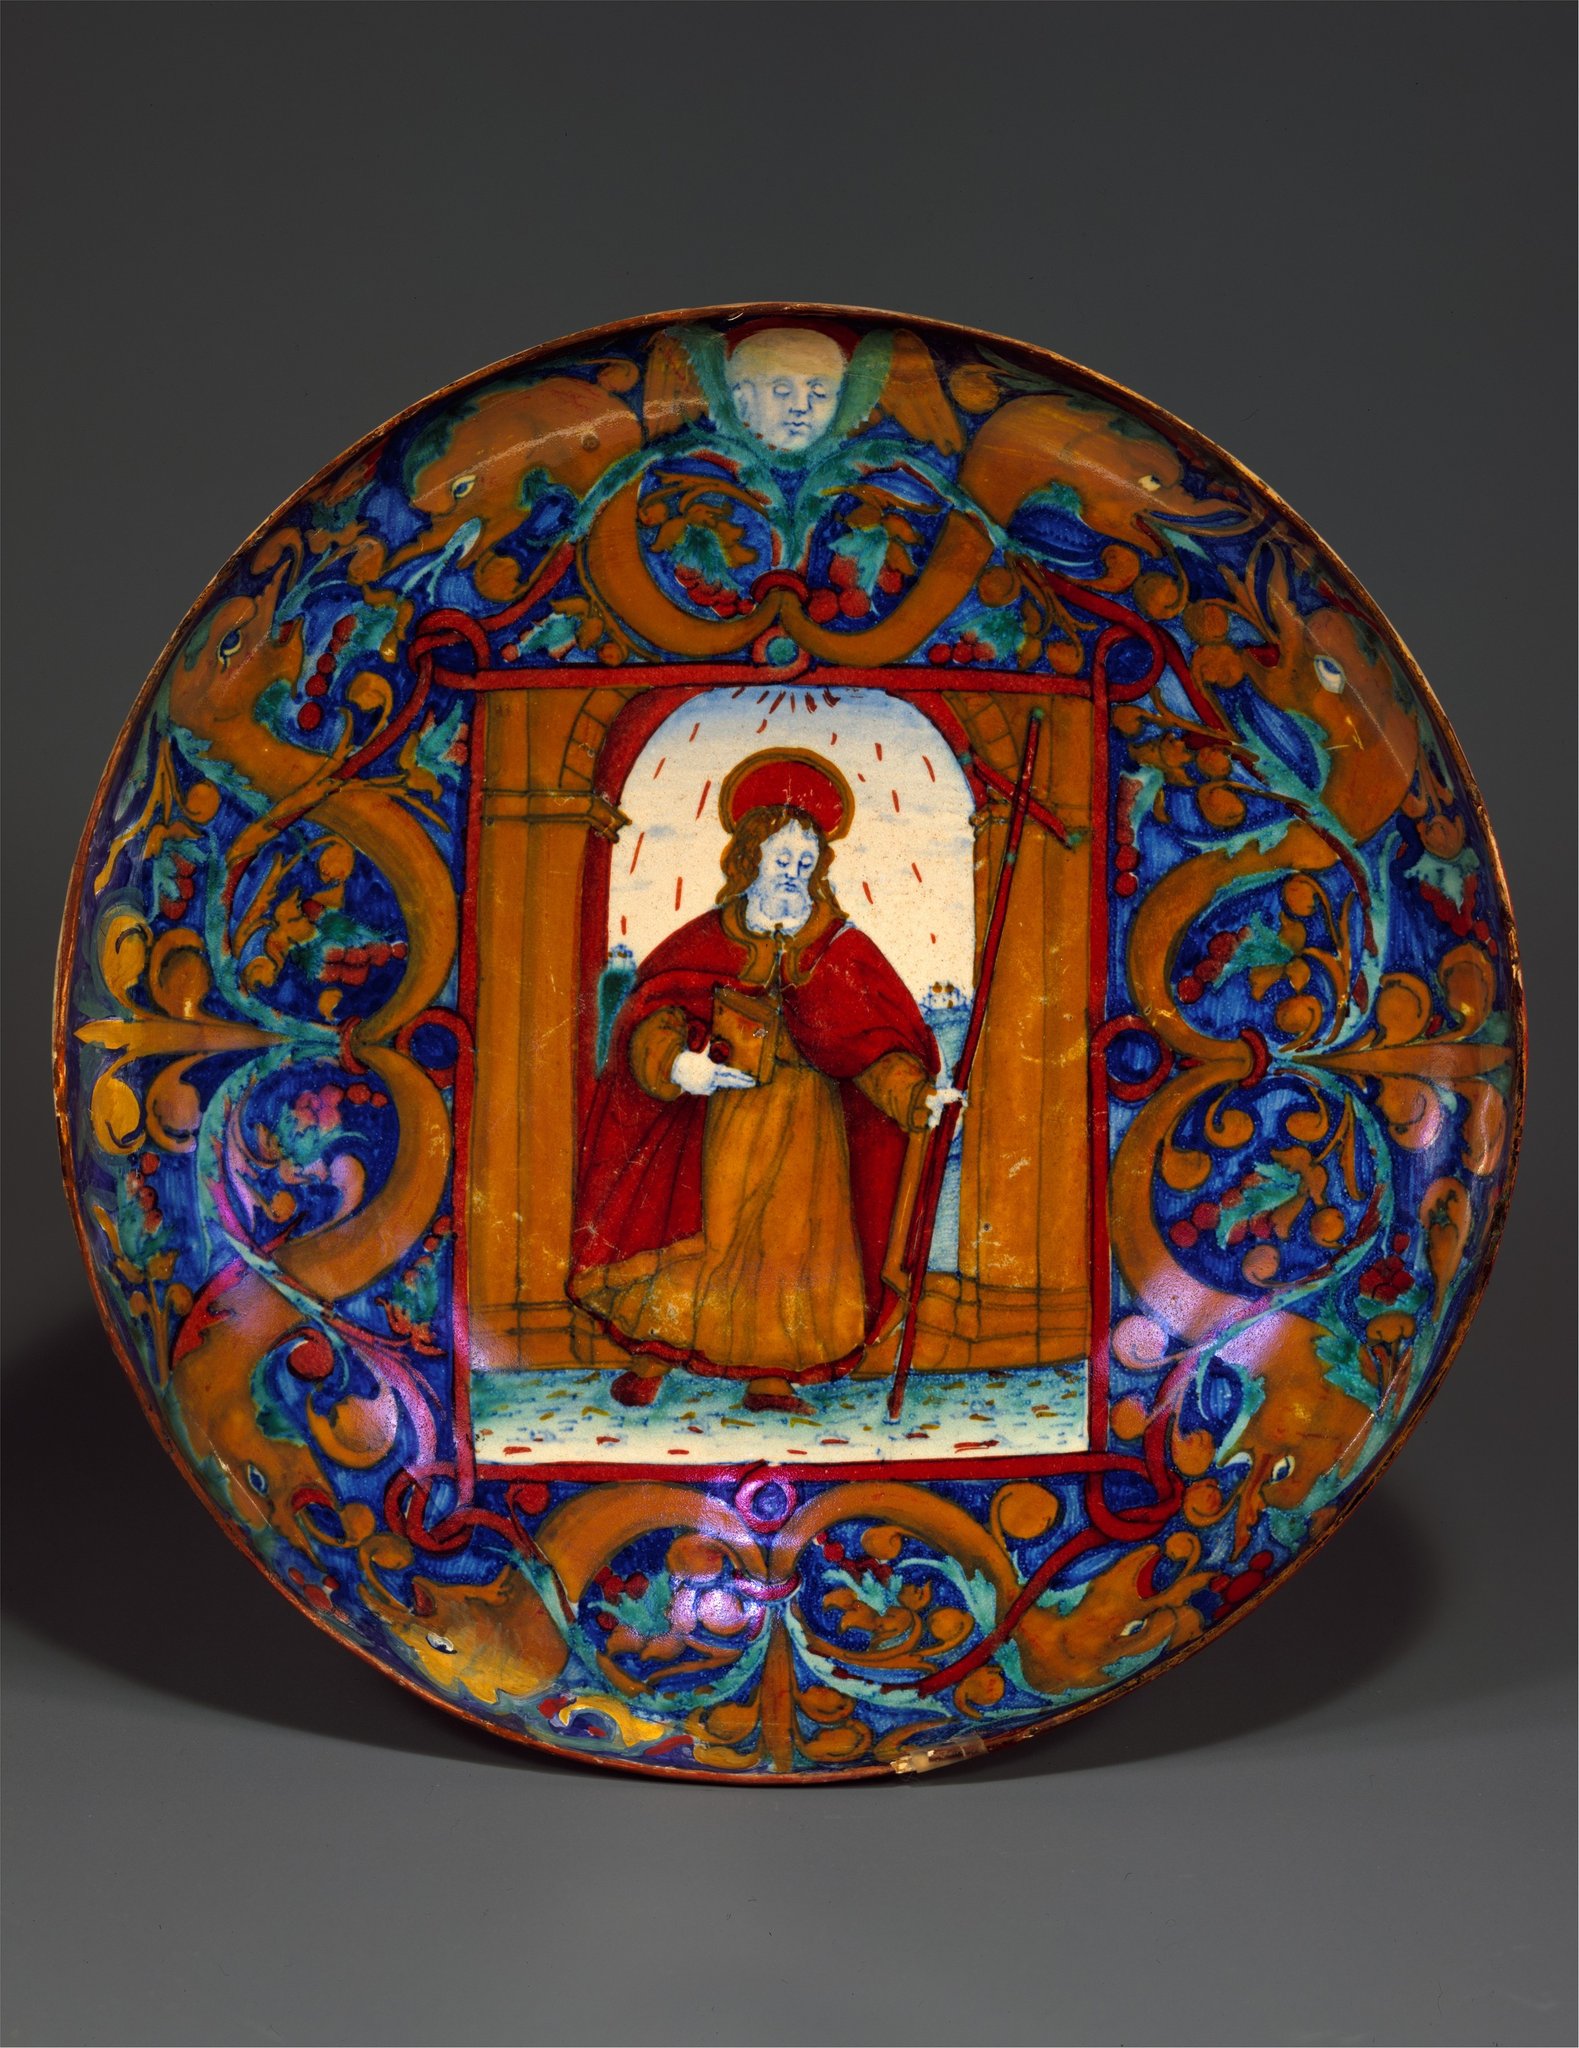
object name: dish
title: Dish (coppa)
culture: italian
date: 1520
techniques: maiolica, glazing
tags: men,cross